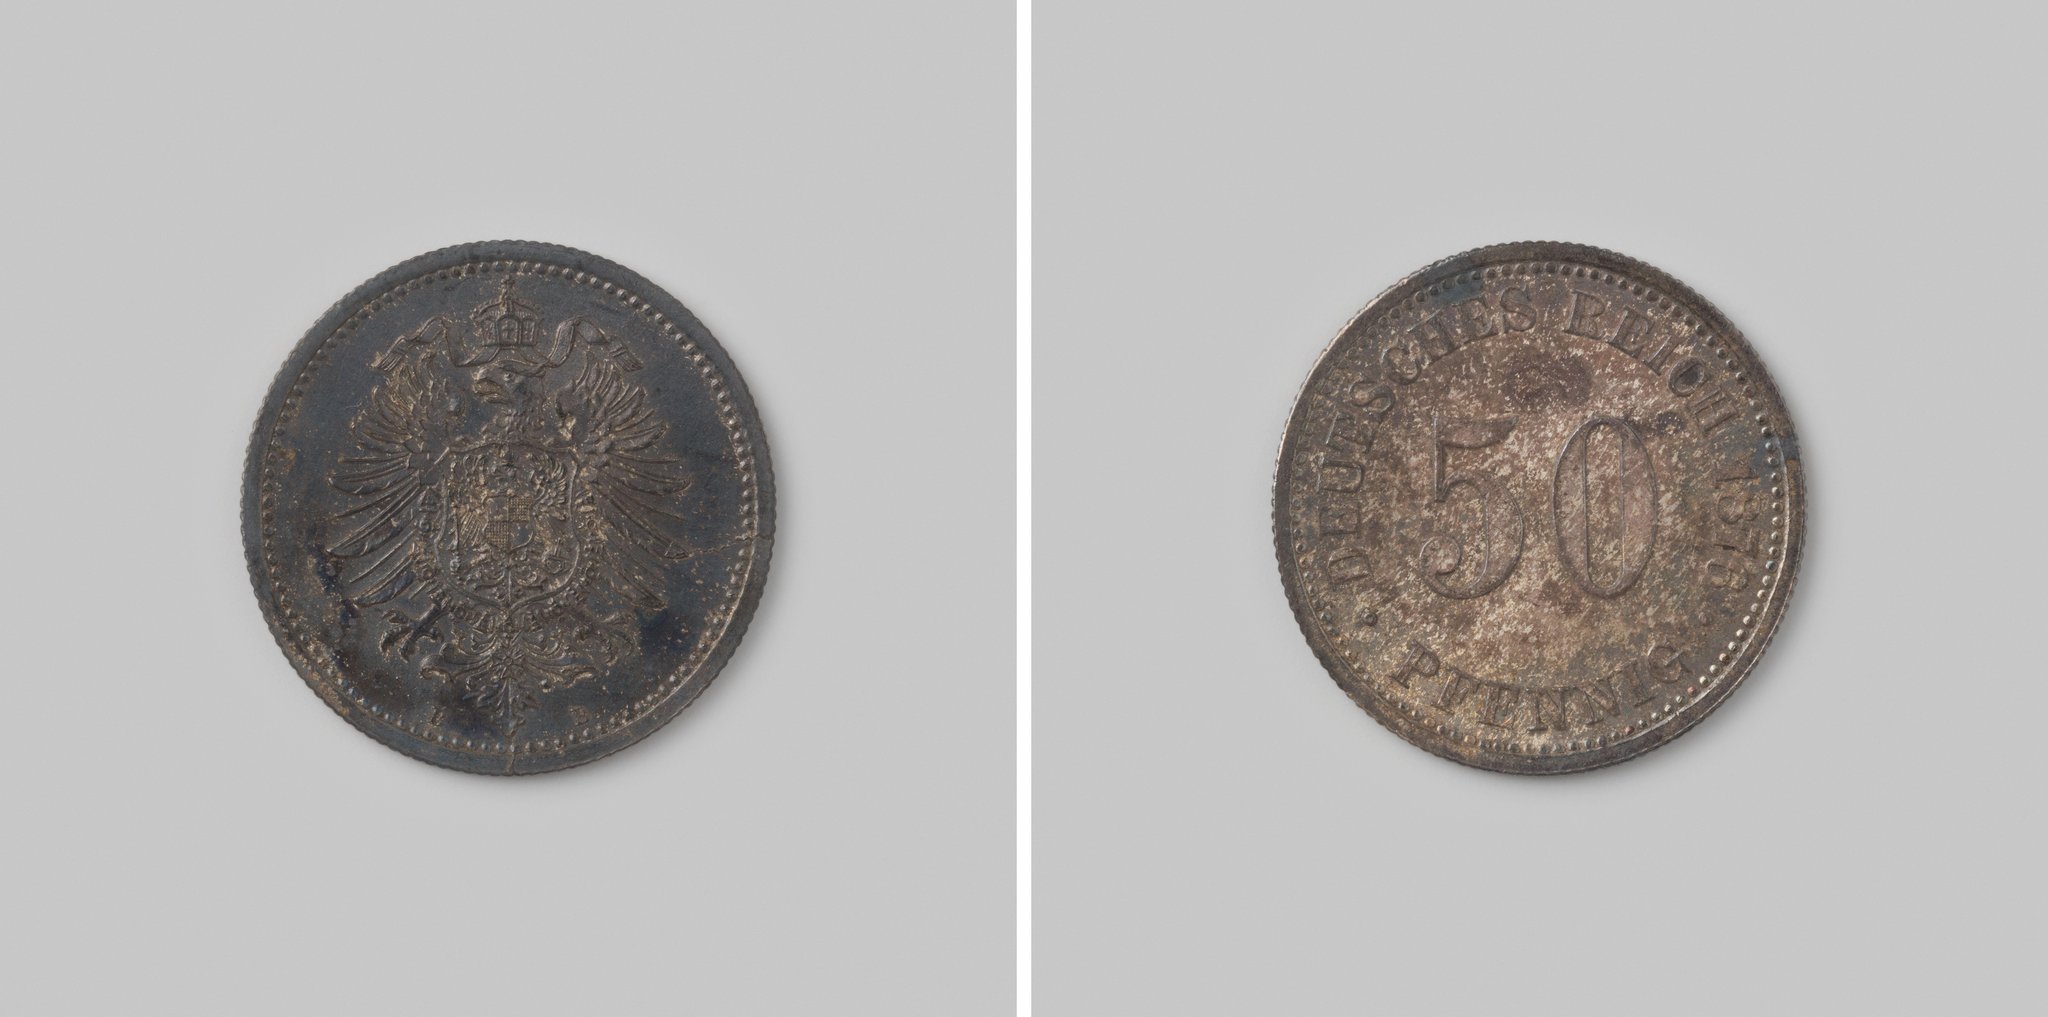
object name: vijftig pfennig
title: 50 Pfennig uit het Duitse Rijk, 1876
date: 1876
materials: silver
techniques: striking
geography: hannover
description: Zilveren munt. Voorzijde: gekroonde enkelkoppige adelaar naar links met op borst door keten van orde met juweel omhangen samengesteld wapenschild. Daaronder twee letters B. Keerzijde: waarde-aanduiding in twee regels. Jaartal in omschrift. Kartelrand.